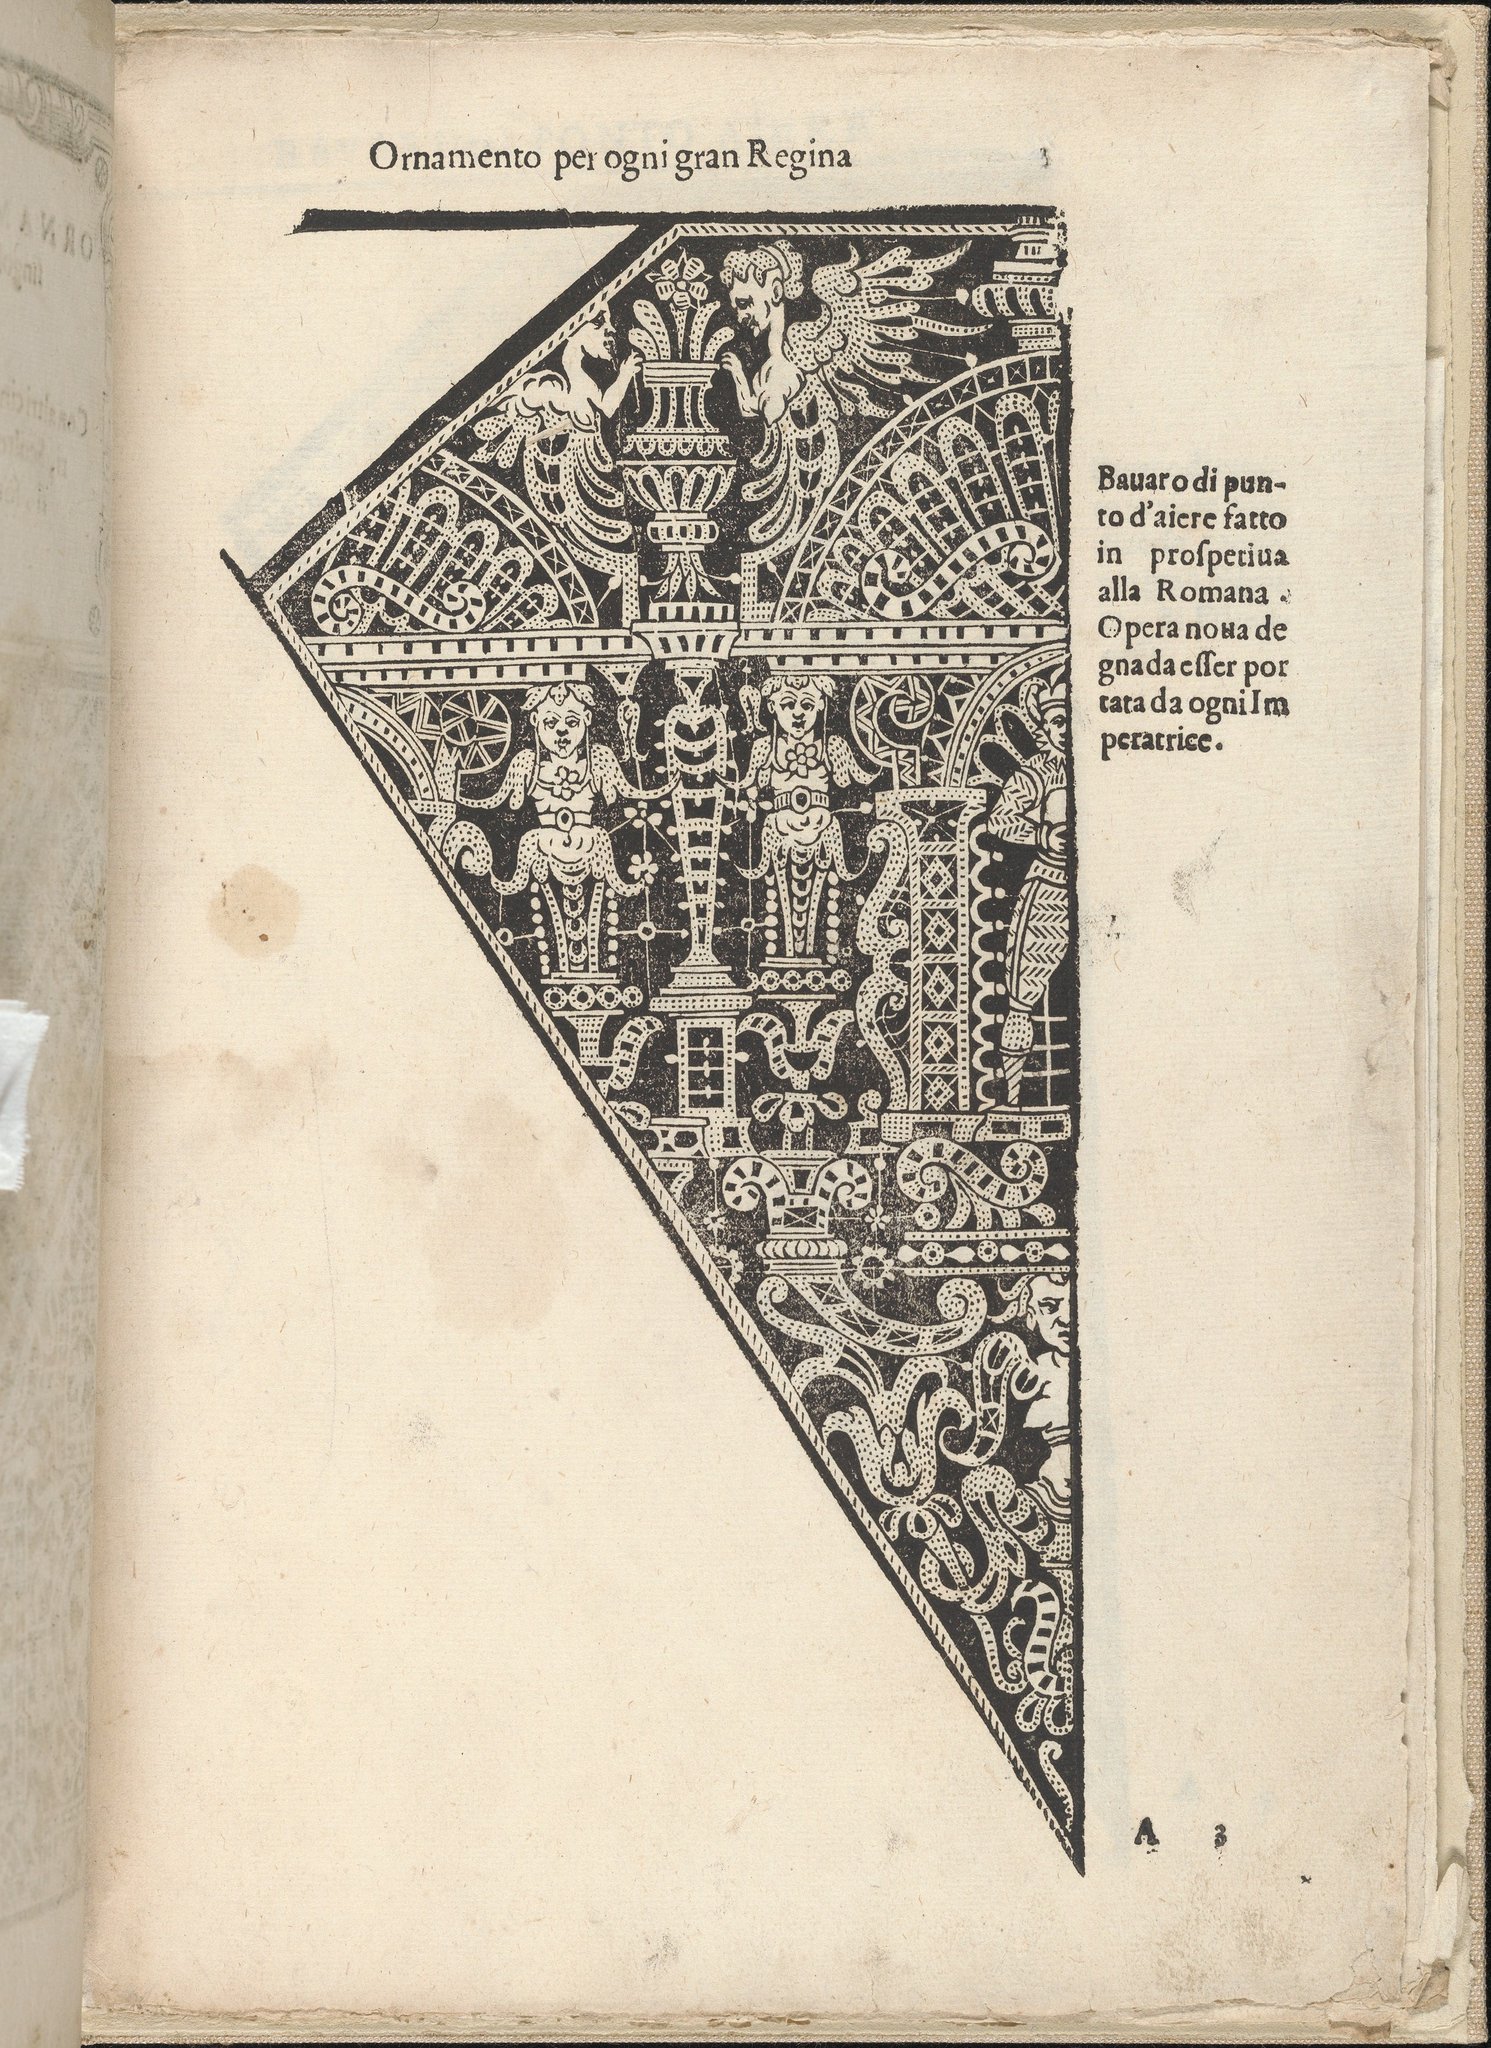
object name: book print ornament architecture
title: Ornamento nobile...Fatta da Lucretia Romana (Libro V of the Corona), page 3 (recto)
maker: cesare vecellio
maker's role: author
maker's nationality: italian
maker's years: 1521-1601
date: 1620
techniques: woodcut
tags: ornament